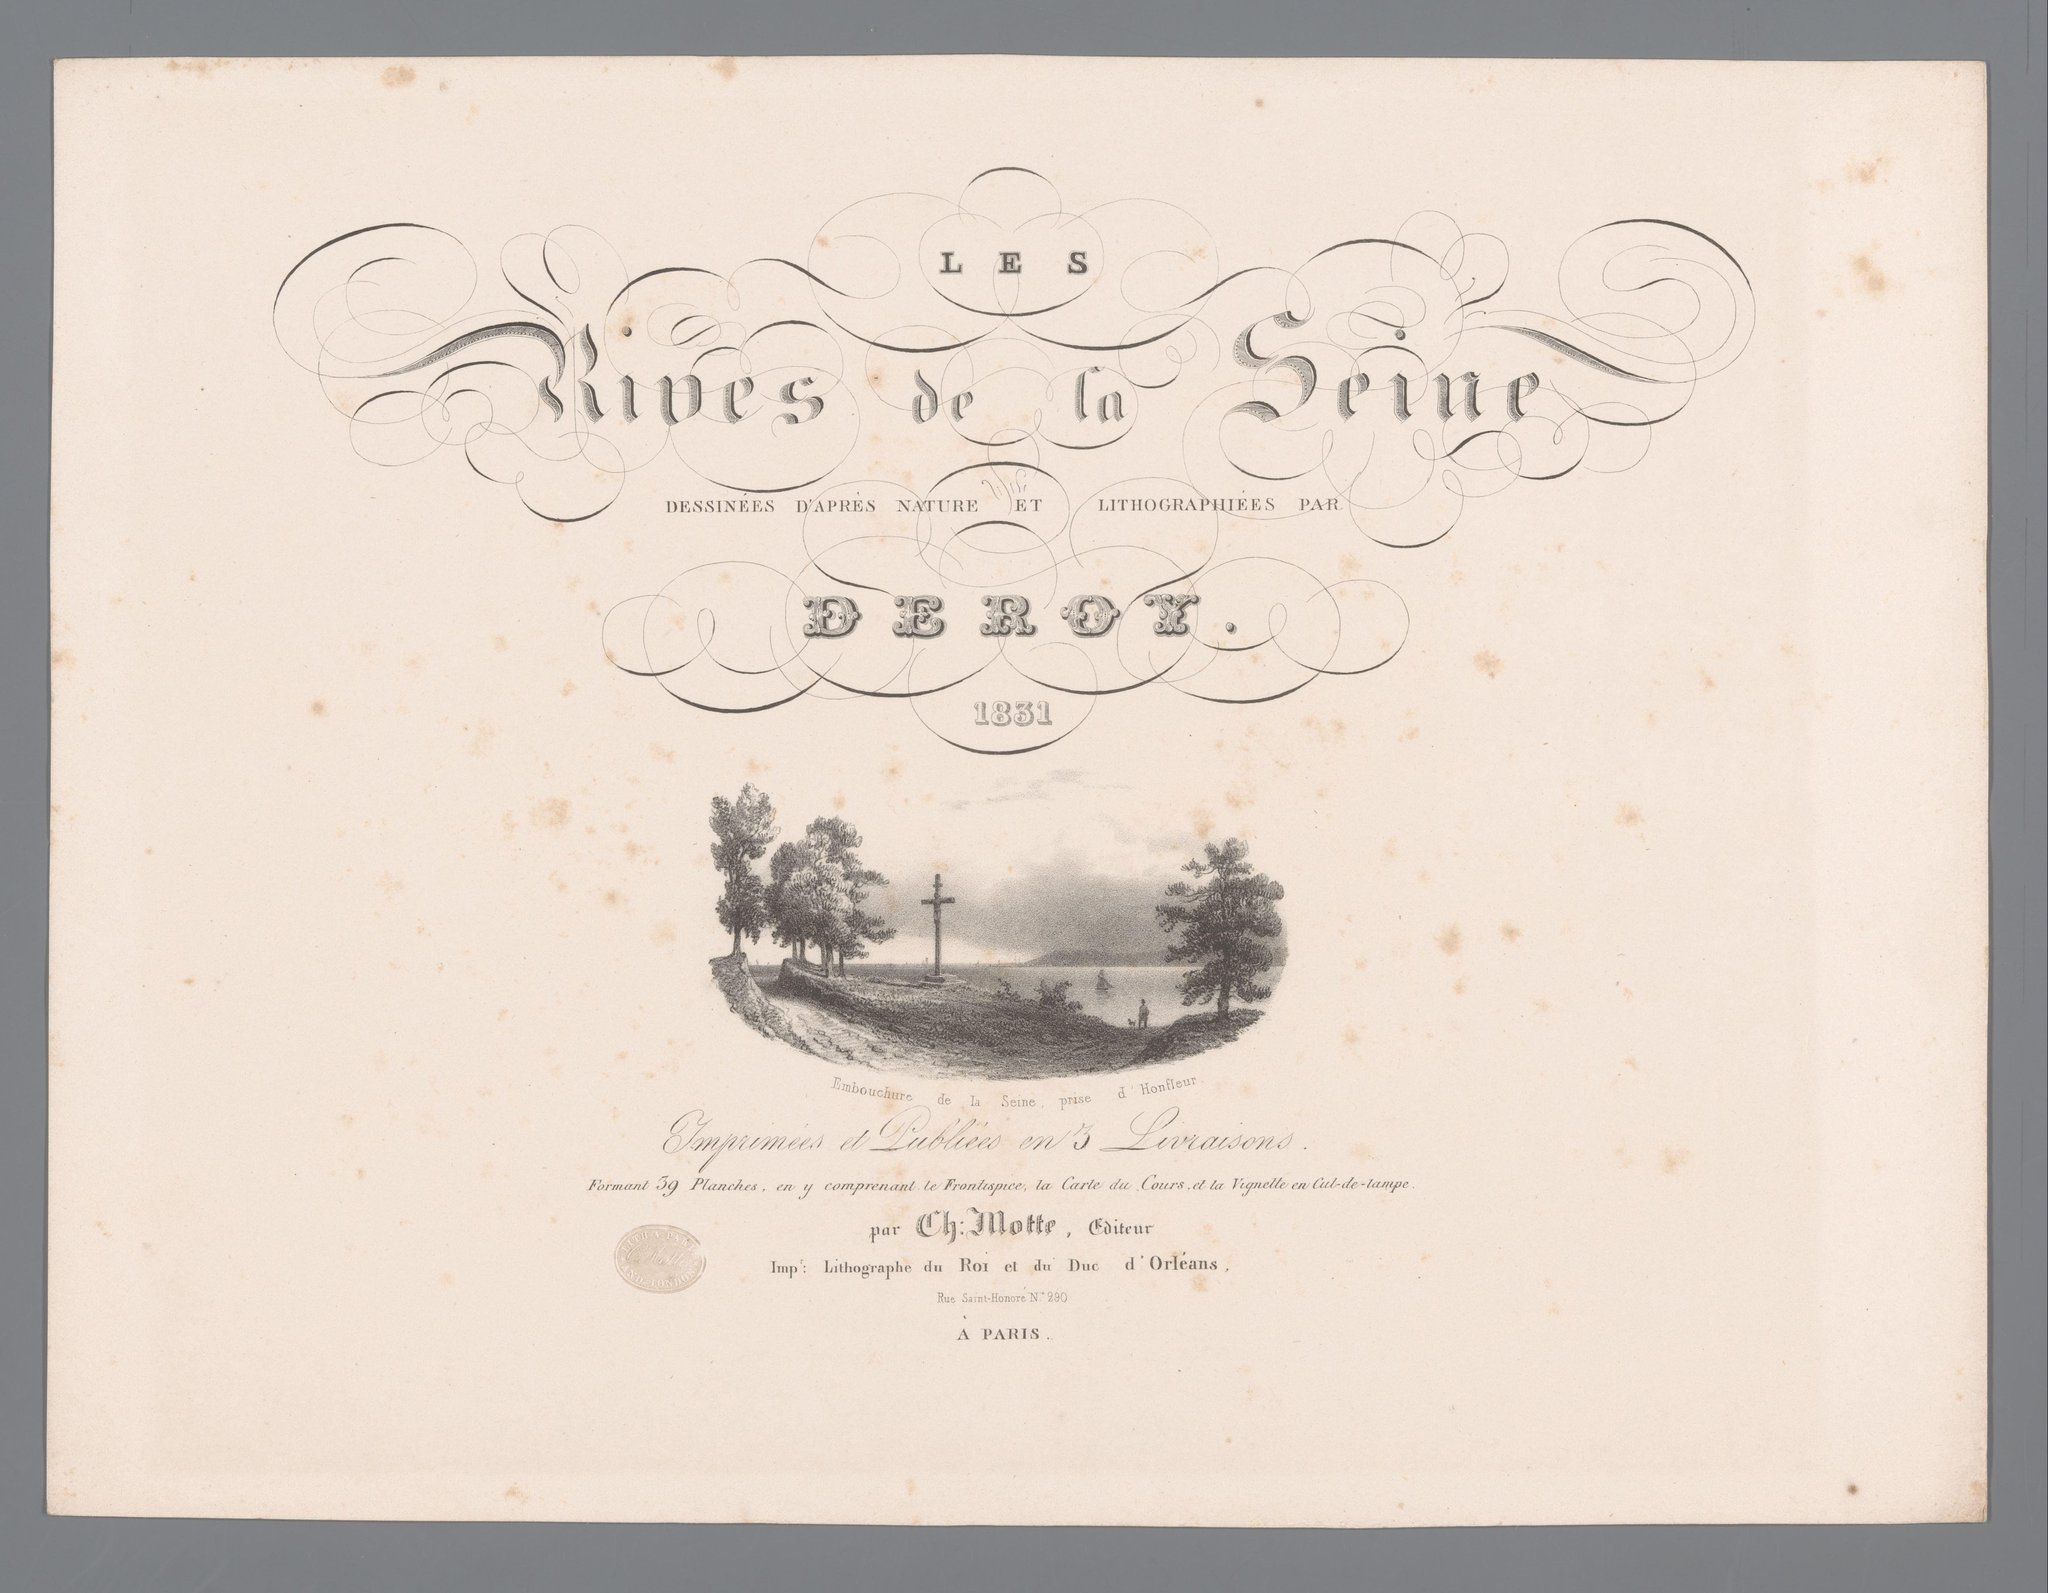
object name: print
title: Gezichten aan de oevers van de Seine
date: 1831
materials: paper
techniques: lithograph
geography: paris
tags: honfleur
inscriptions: collector's mark: Lugt 2228a, check stamp: Lugt 1828b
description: Prent maakt deel uit van een omslag met veertien prenten.